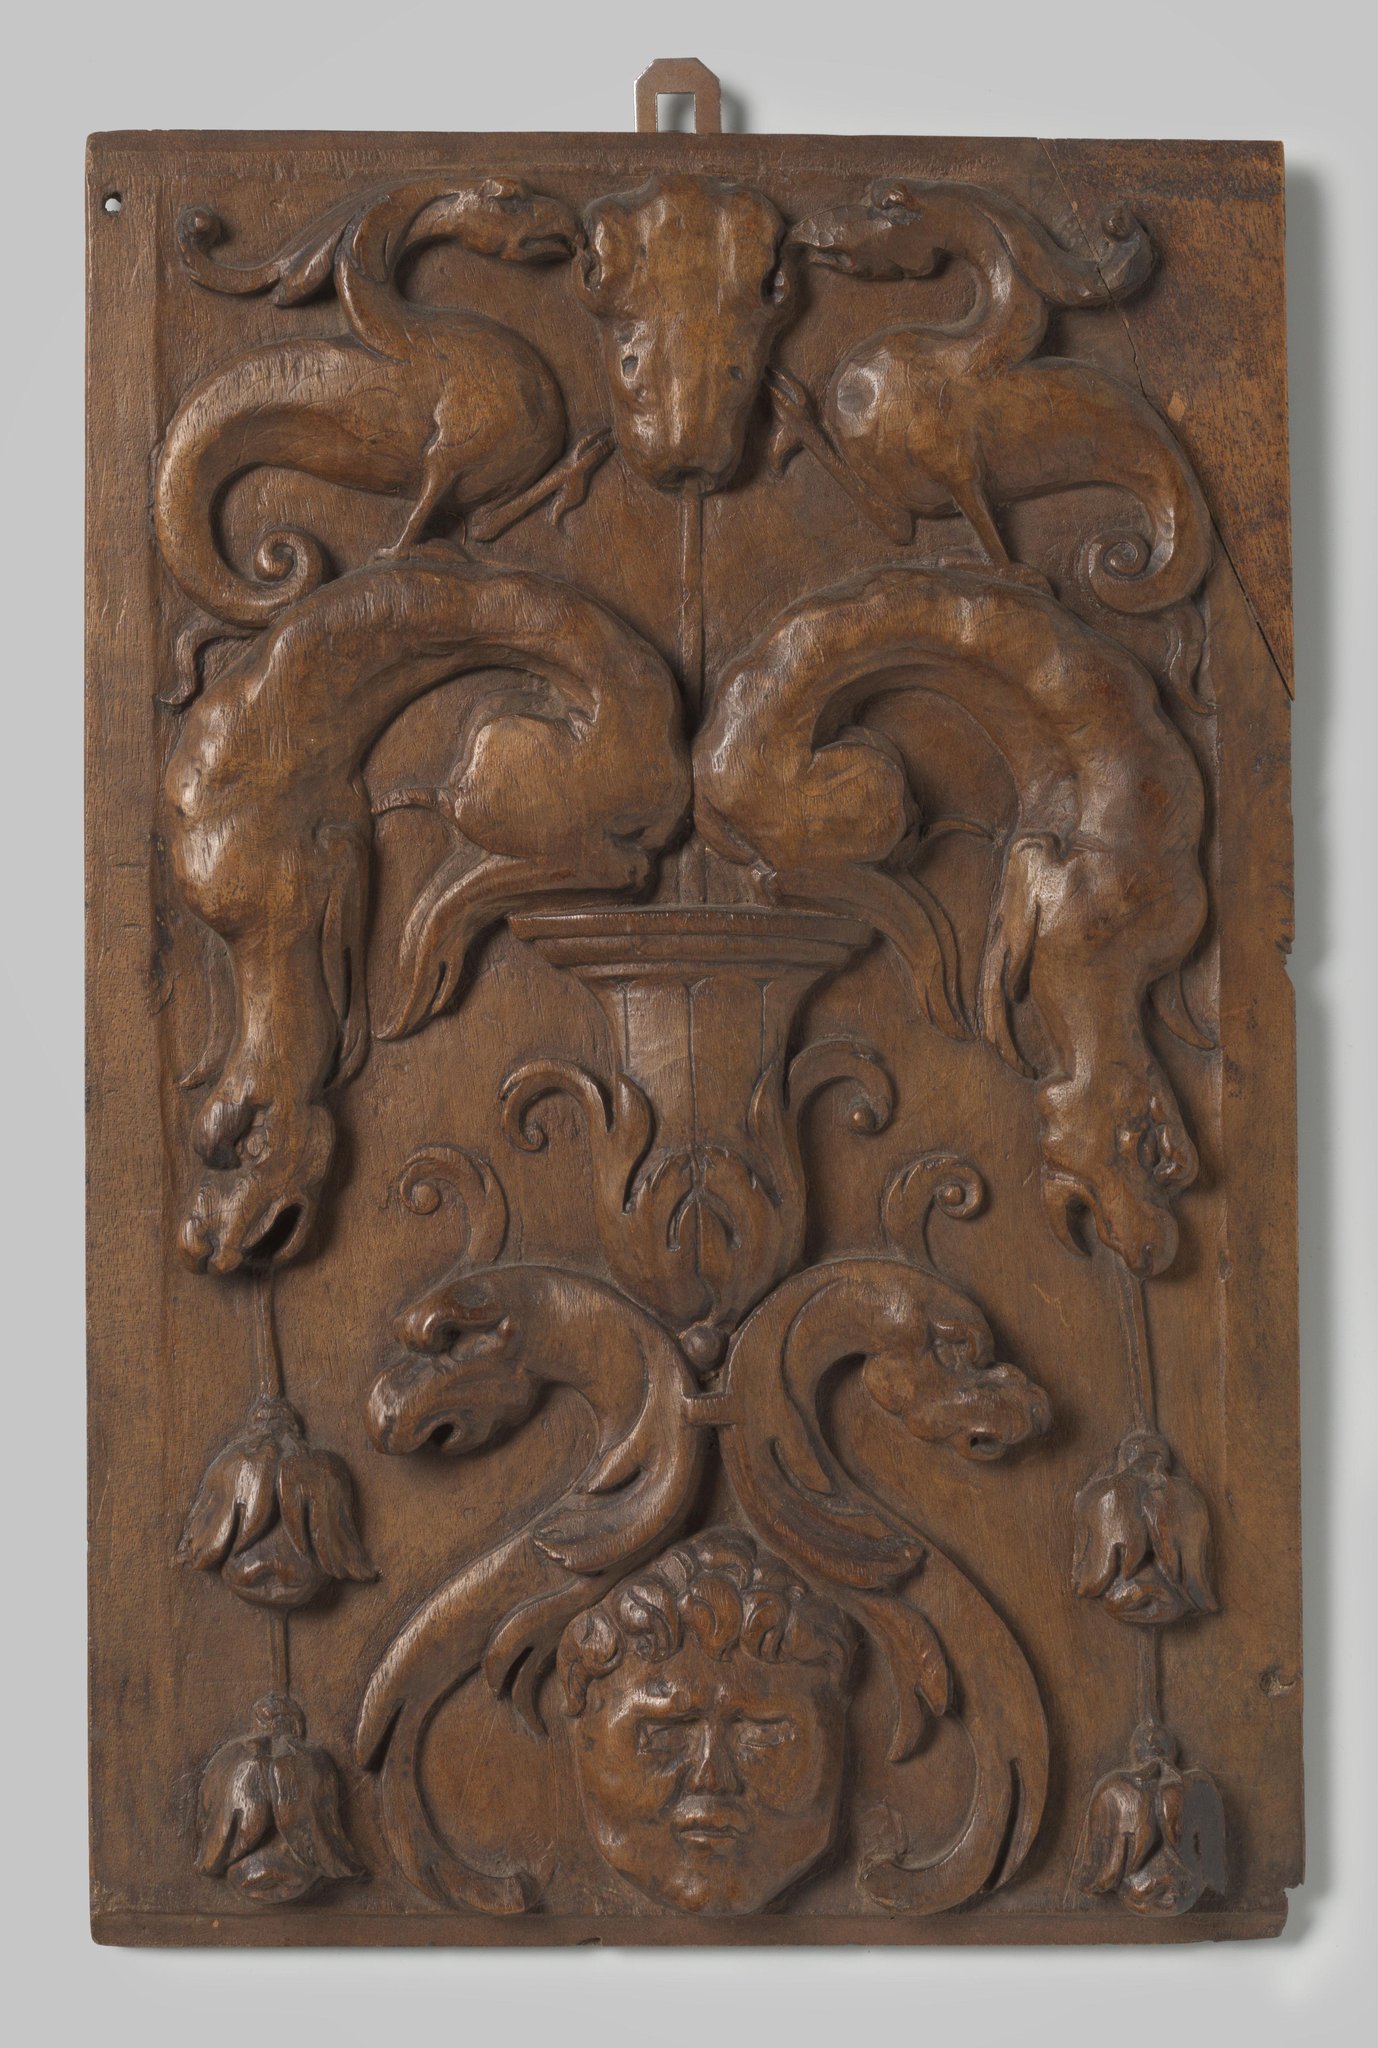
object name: kastpaneel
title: Kistpaneel met grotesken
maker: Anonymous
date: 1500-1600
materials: wood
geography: southern netherlands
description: Notenhouten kast- of kistpaneel versierd met grotesken, die ondermeer een bucranium, draken, gebogen naakte mannenfiguren, drakenkoppen, slangen, een maskaron en een lintmotief vertonen.